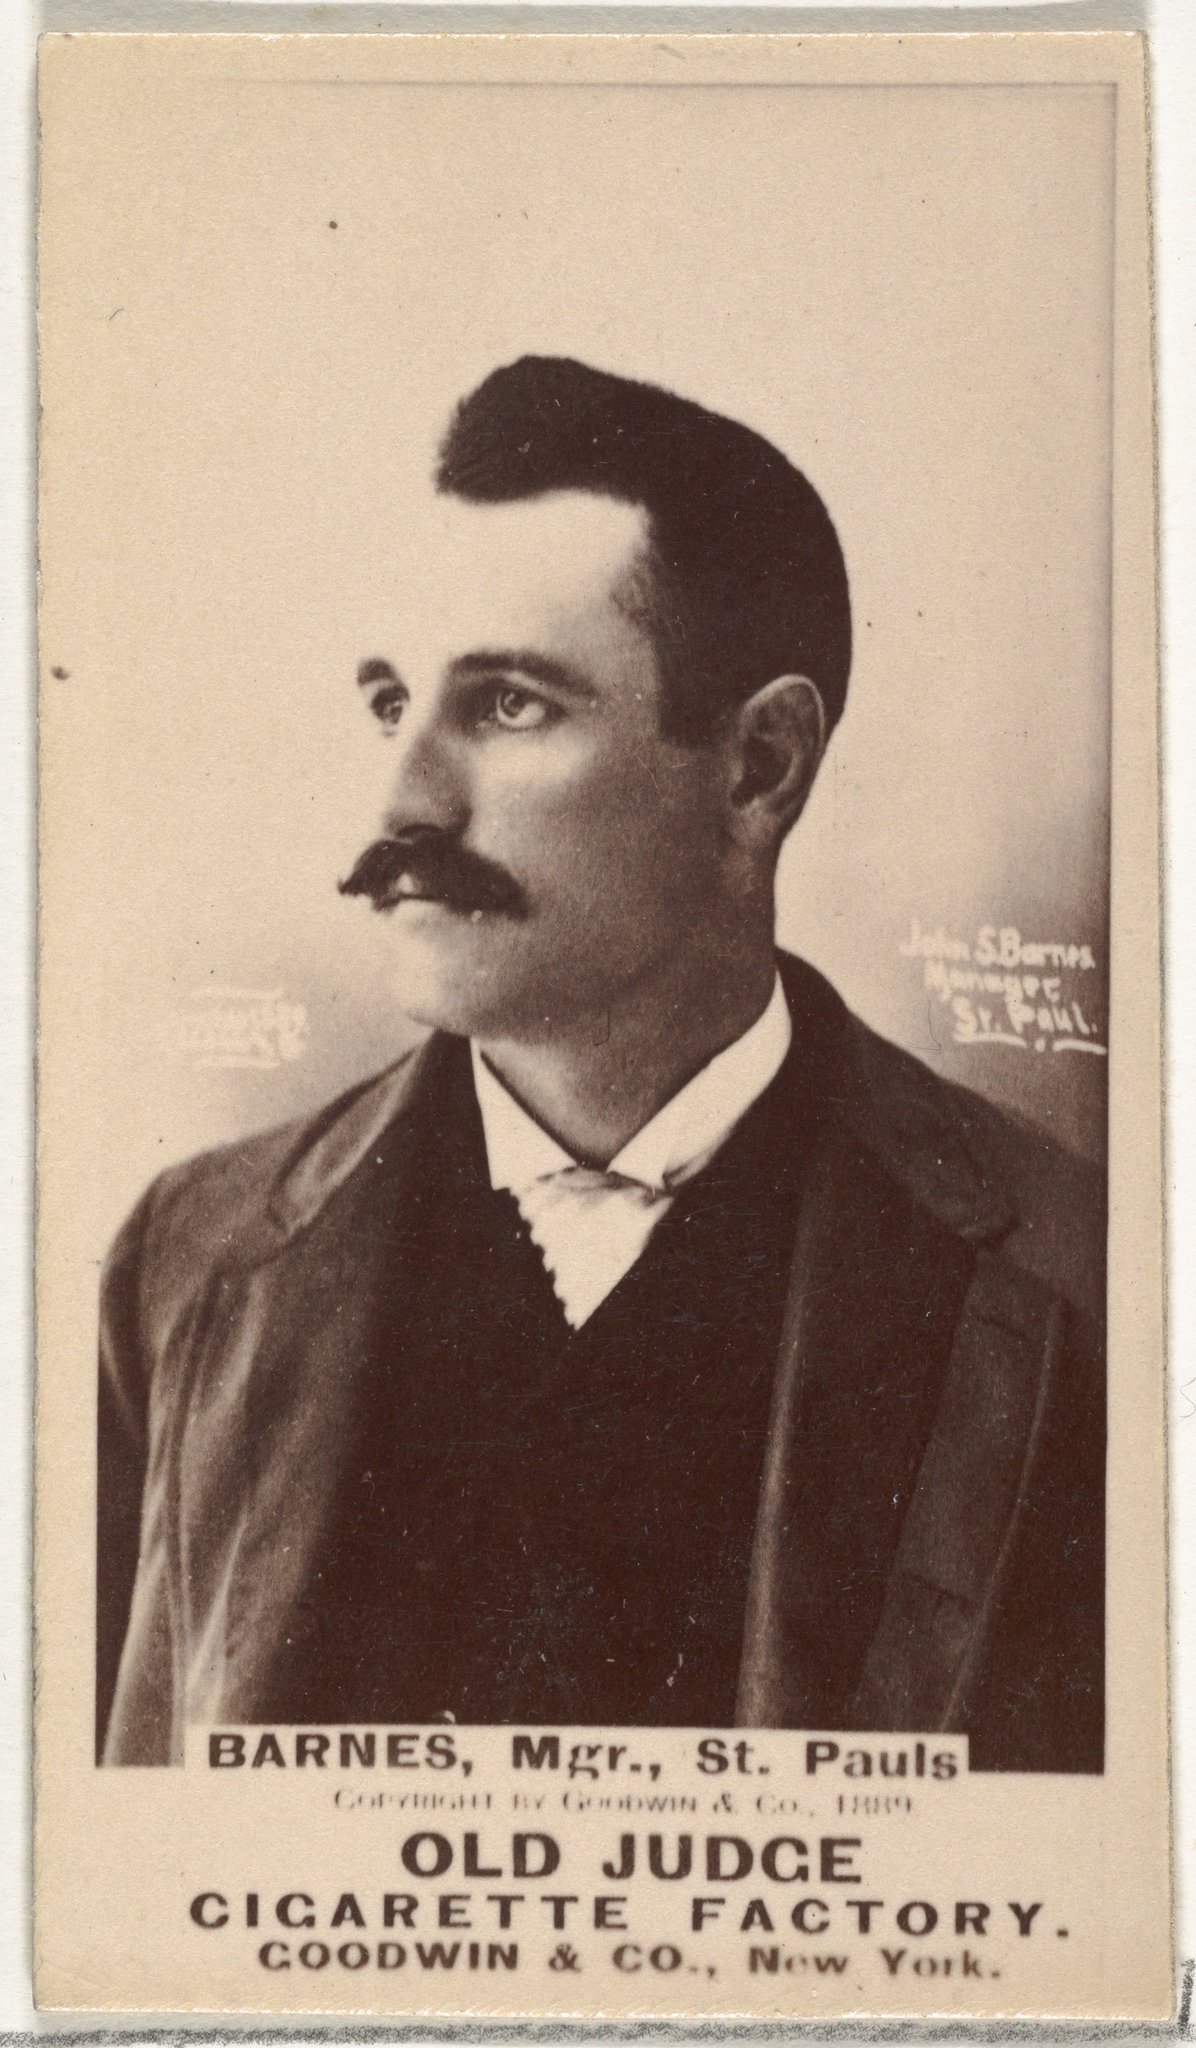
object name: baseball card, photograph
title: William H. "Bill" Barnes, Manager, St. Paul Apostles, from the Old Judge series (N172) for Old Judge Cigarettes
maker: goodwin & company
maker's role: publisher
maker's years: 1850-1950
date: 1889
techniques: albumen silver print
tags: men,portraits,baseball